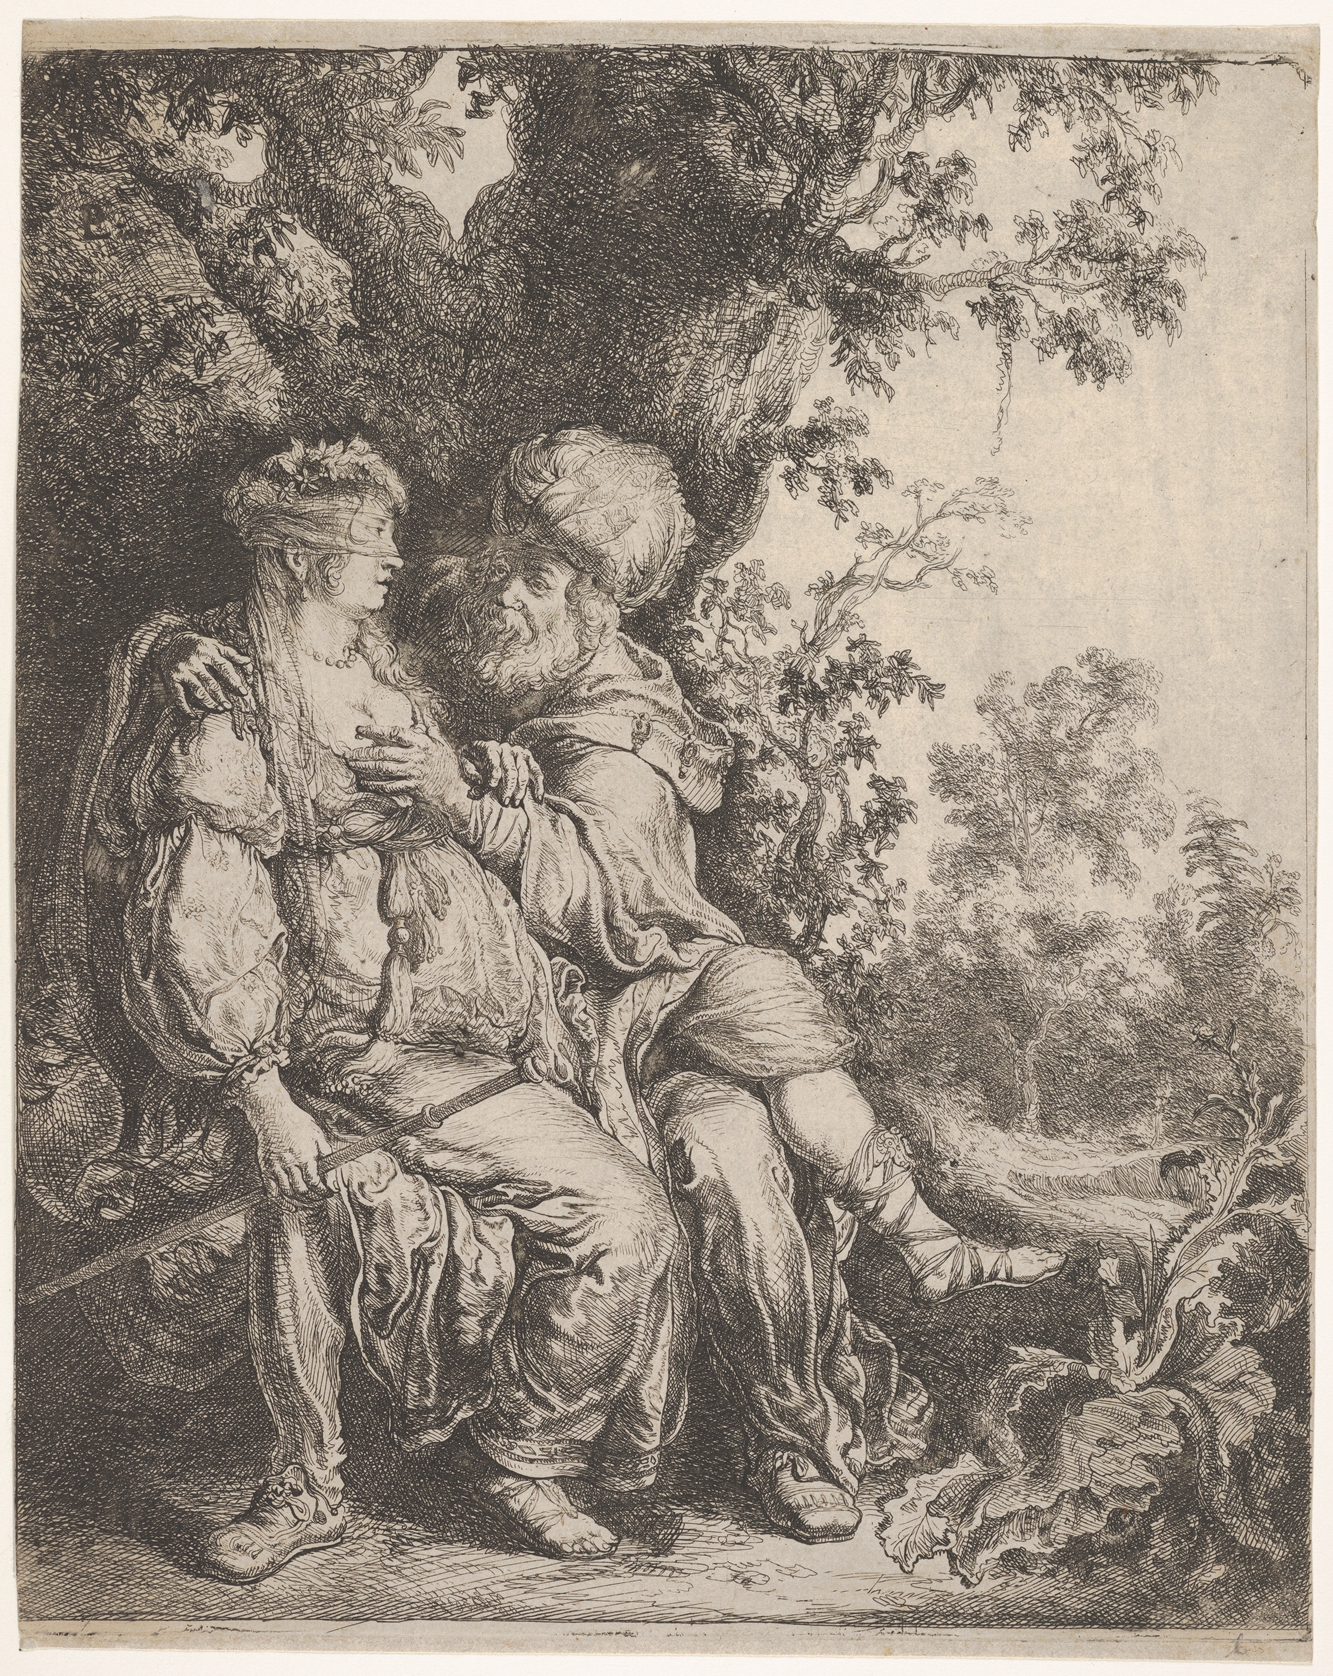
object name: print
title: Judah and Tamar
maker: pieter lastman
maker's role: artist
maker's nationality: dutch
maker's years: 1583-1633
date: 1595-1633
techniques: etching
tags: men,women